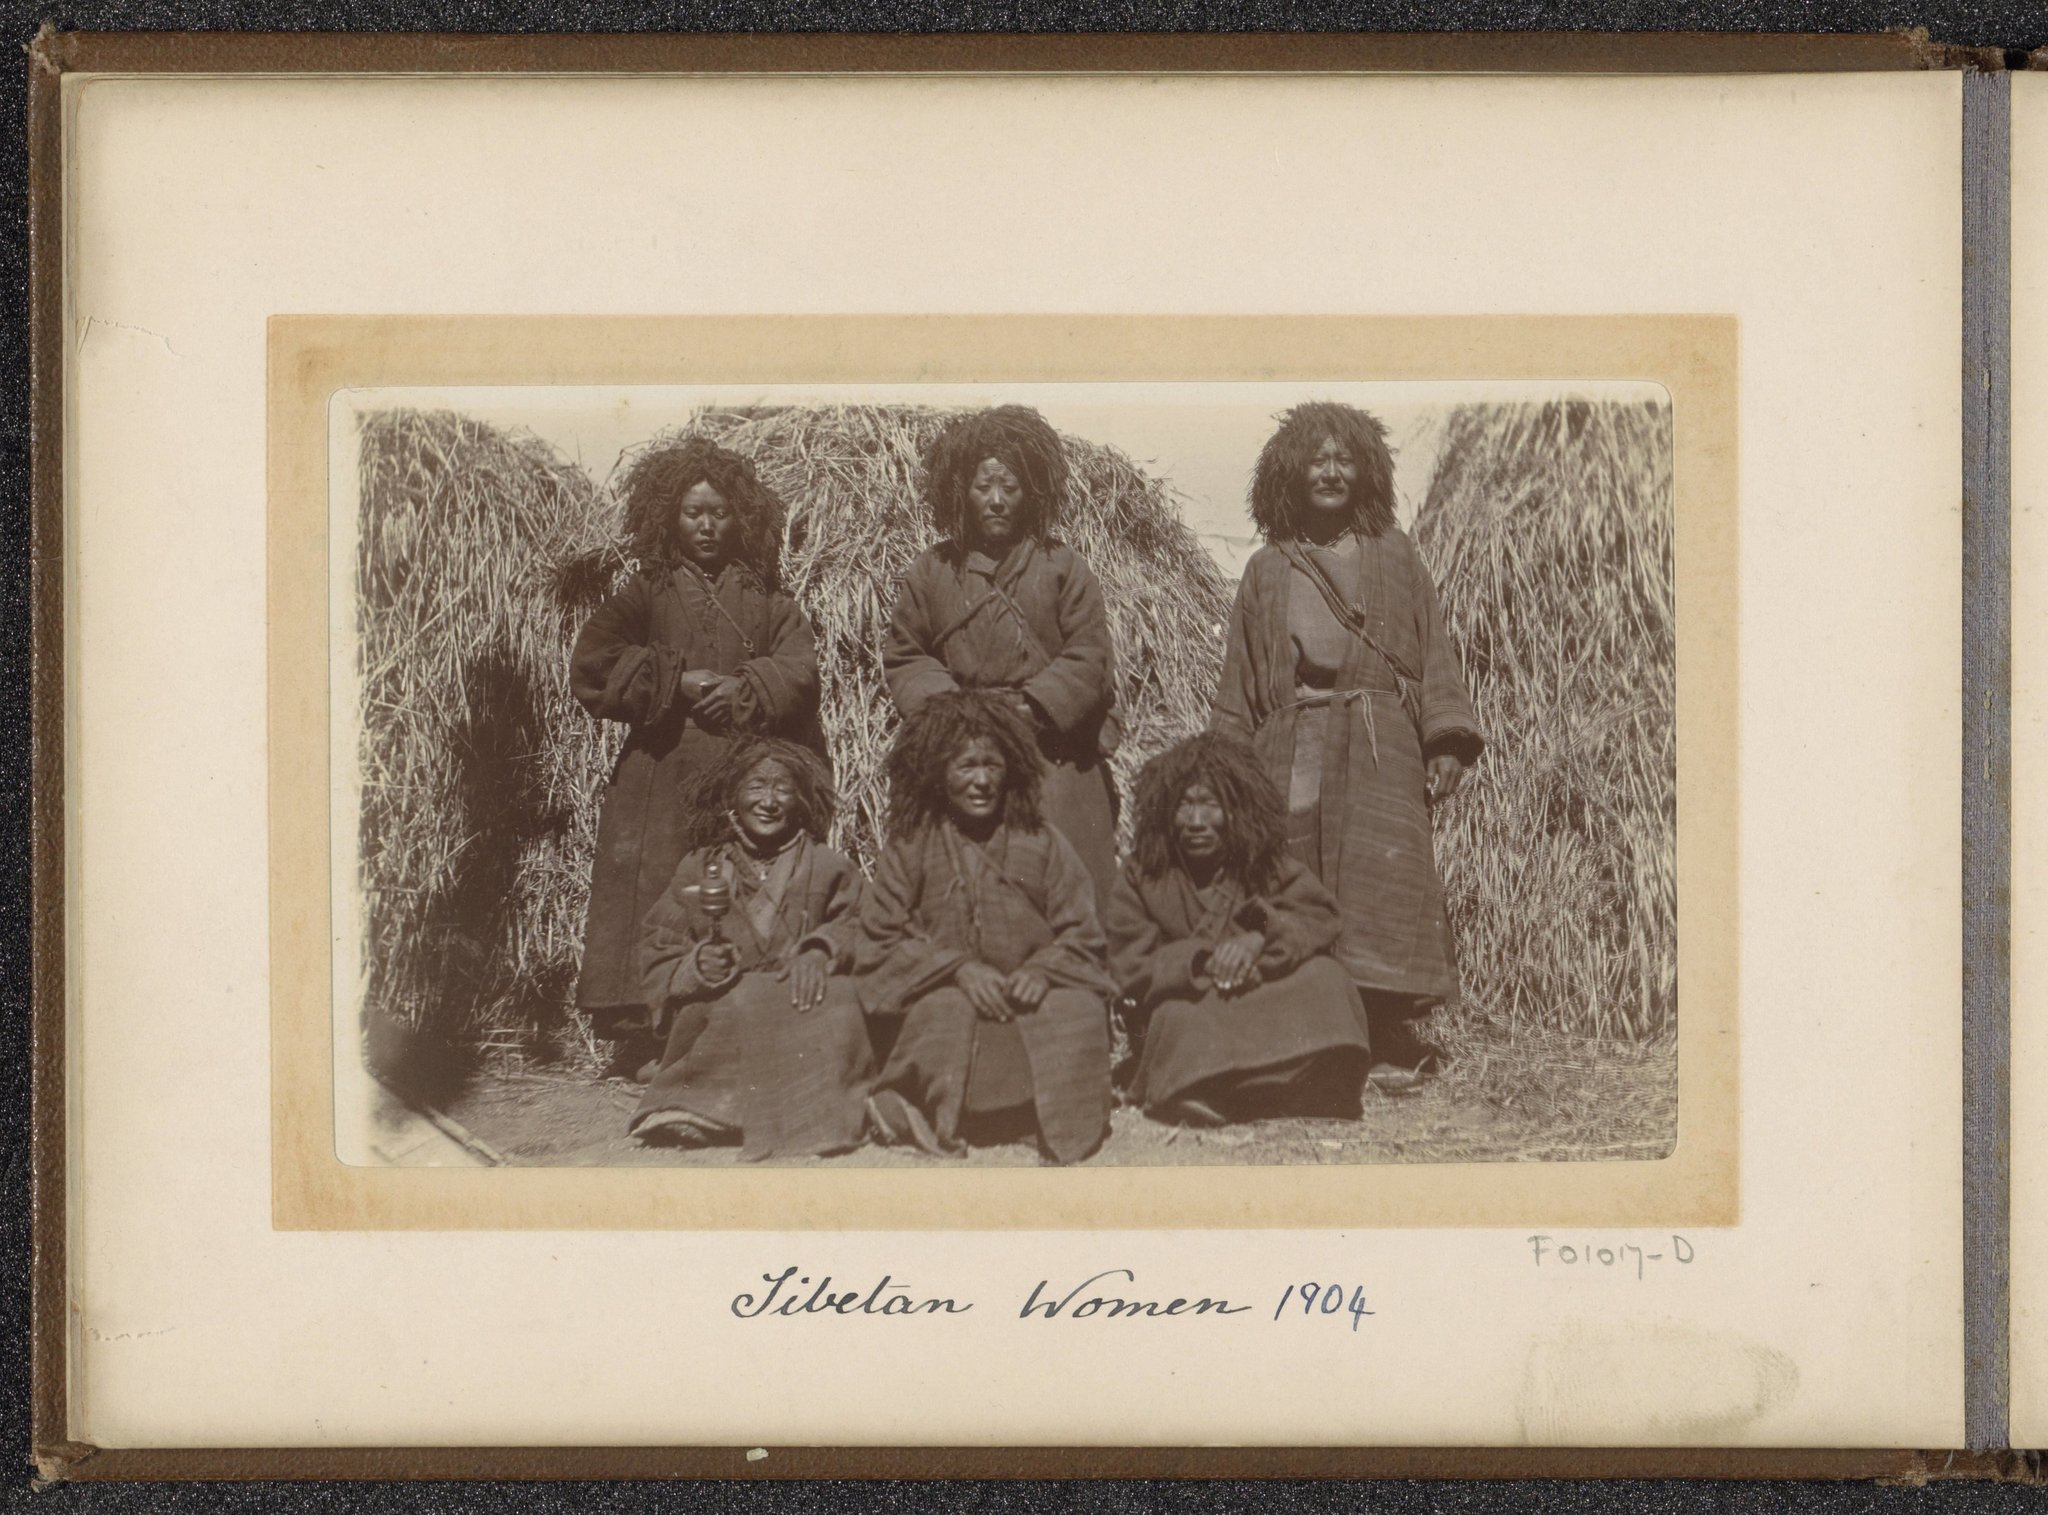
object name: photograph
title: Tibetan nuns of the Taktshang monastery, Bhutan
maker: d.t. dalton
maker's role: sergeant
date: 1904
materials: paper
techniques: gelatin silver print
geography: bhutan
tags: temple servants ~ hinduism, buddhism, jainism - hh - priestess, head-gear, styles of hairdress - aa - ~ women, clothes covering the entire body, hay-stack, anonymous historical person portrayed - bb - woman, paro taktsang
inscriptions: title: ‘Tibetan Women 1904’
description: De naam Taktshang betekent Tijgernest. Het klooster is daarom ook vaak bekend als Tiger's Nest.